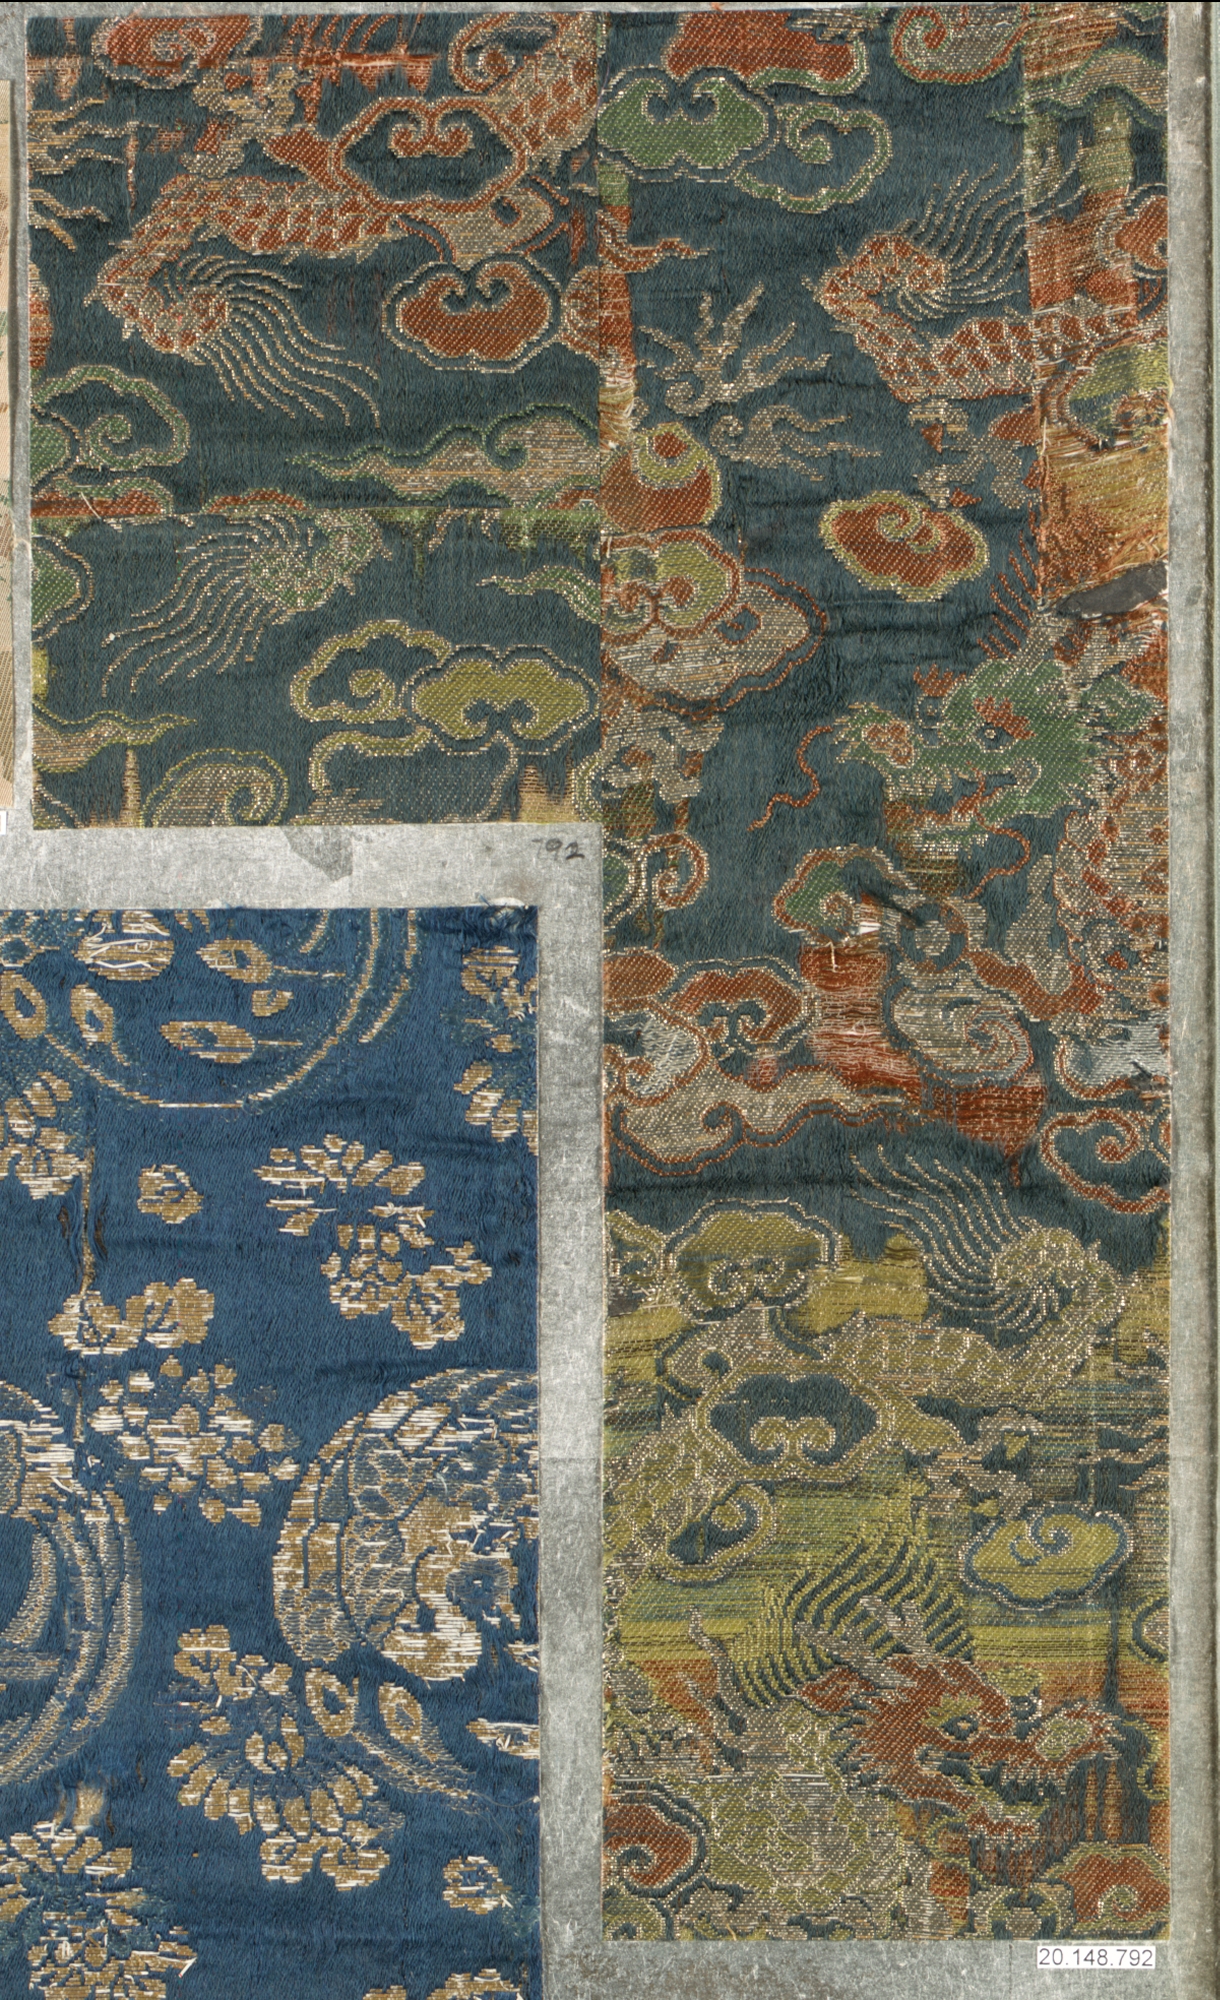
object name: piece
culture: japanese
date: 1601-1700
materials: silk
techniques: compound weave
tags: dragons,flowers